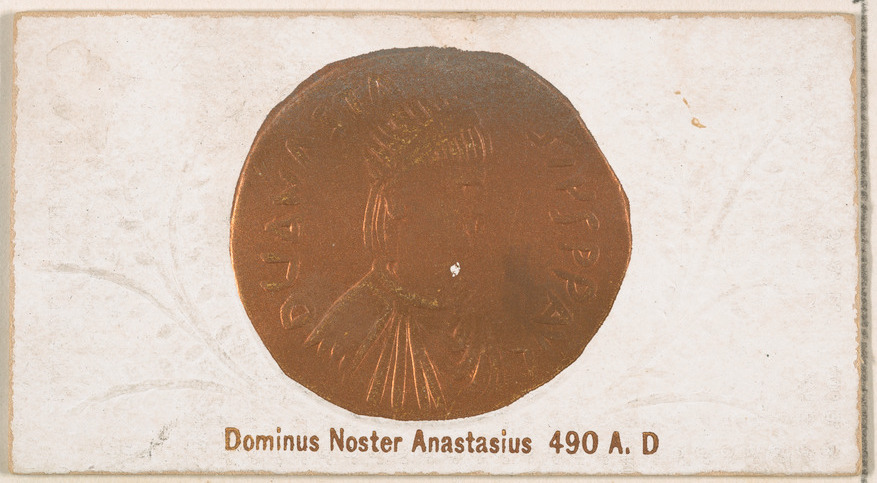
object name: print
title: Dominus Noster Anastasius, 490 A.D., from the Ancient Coins series (N180) issued by Wm. S. Kimball & Co.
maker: william s. kimball & company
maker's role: publisher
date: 1888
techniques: color lithograph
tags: men,coins